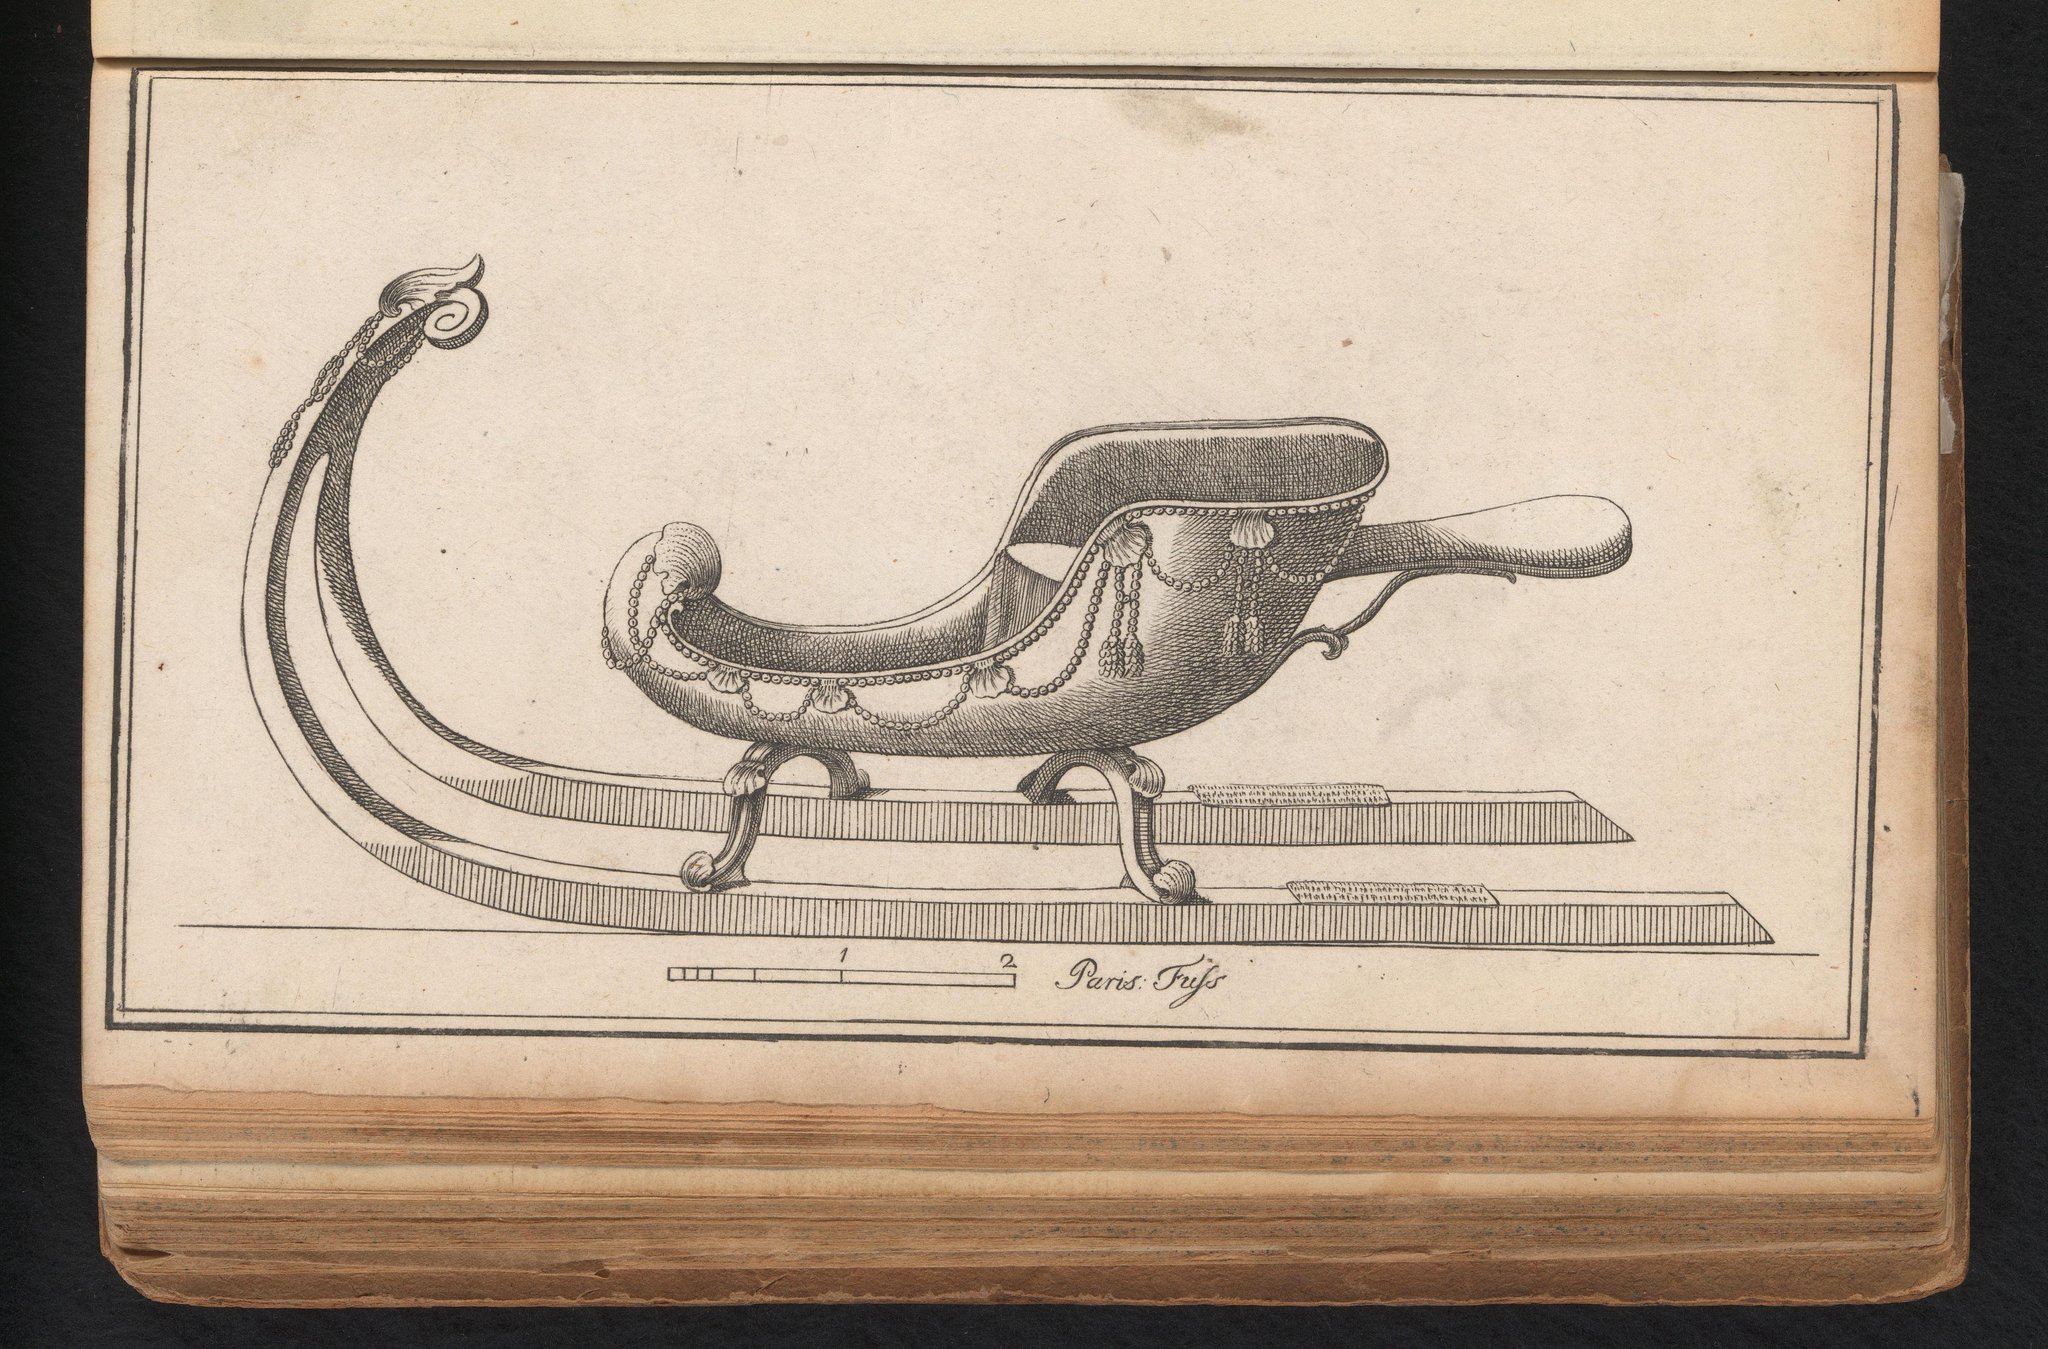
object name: fashion print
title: Journal des Luxus und der Moden 1786, Band I, T. 28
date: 1786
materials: paper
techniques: etching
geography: weimar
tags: fashion plates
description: Een arreslee volgens de laatste smaak. Prent uit het modetijdschrift Journal des Luxus und der Moden, uitgegeven door Friedrich Justin Bertuch en Georg Melchior Kraus, Weimar, 1786-1826.